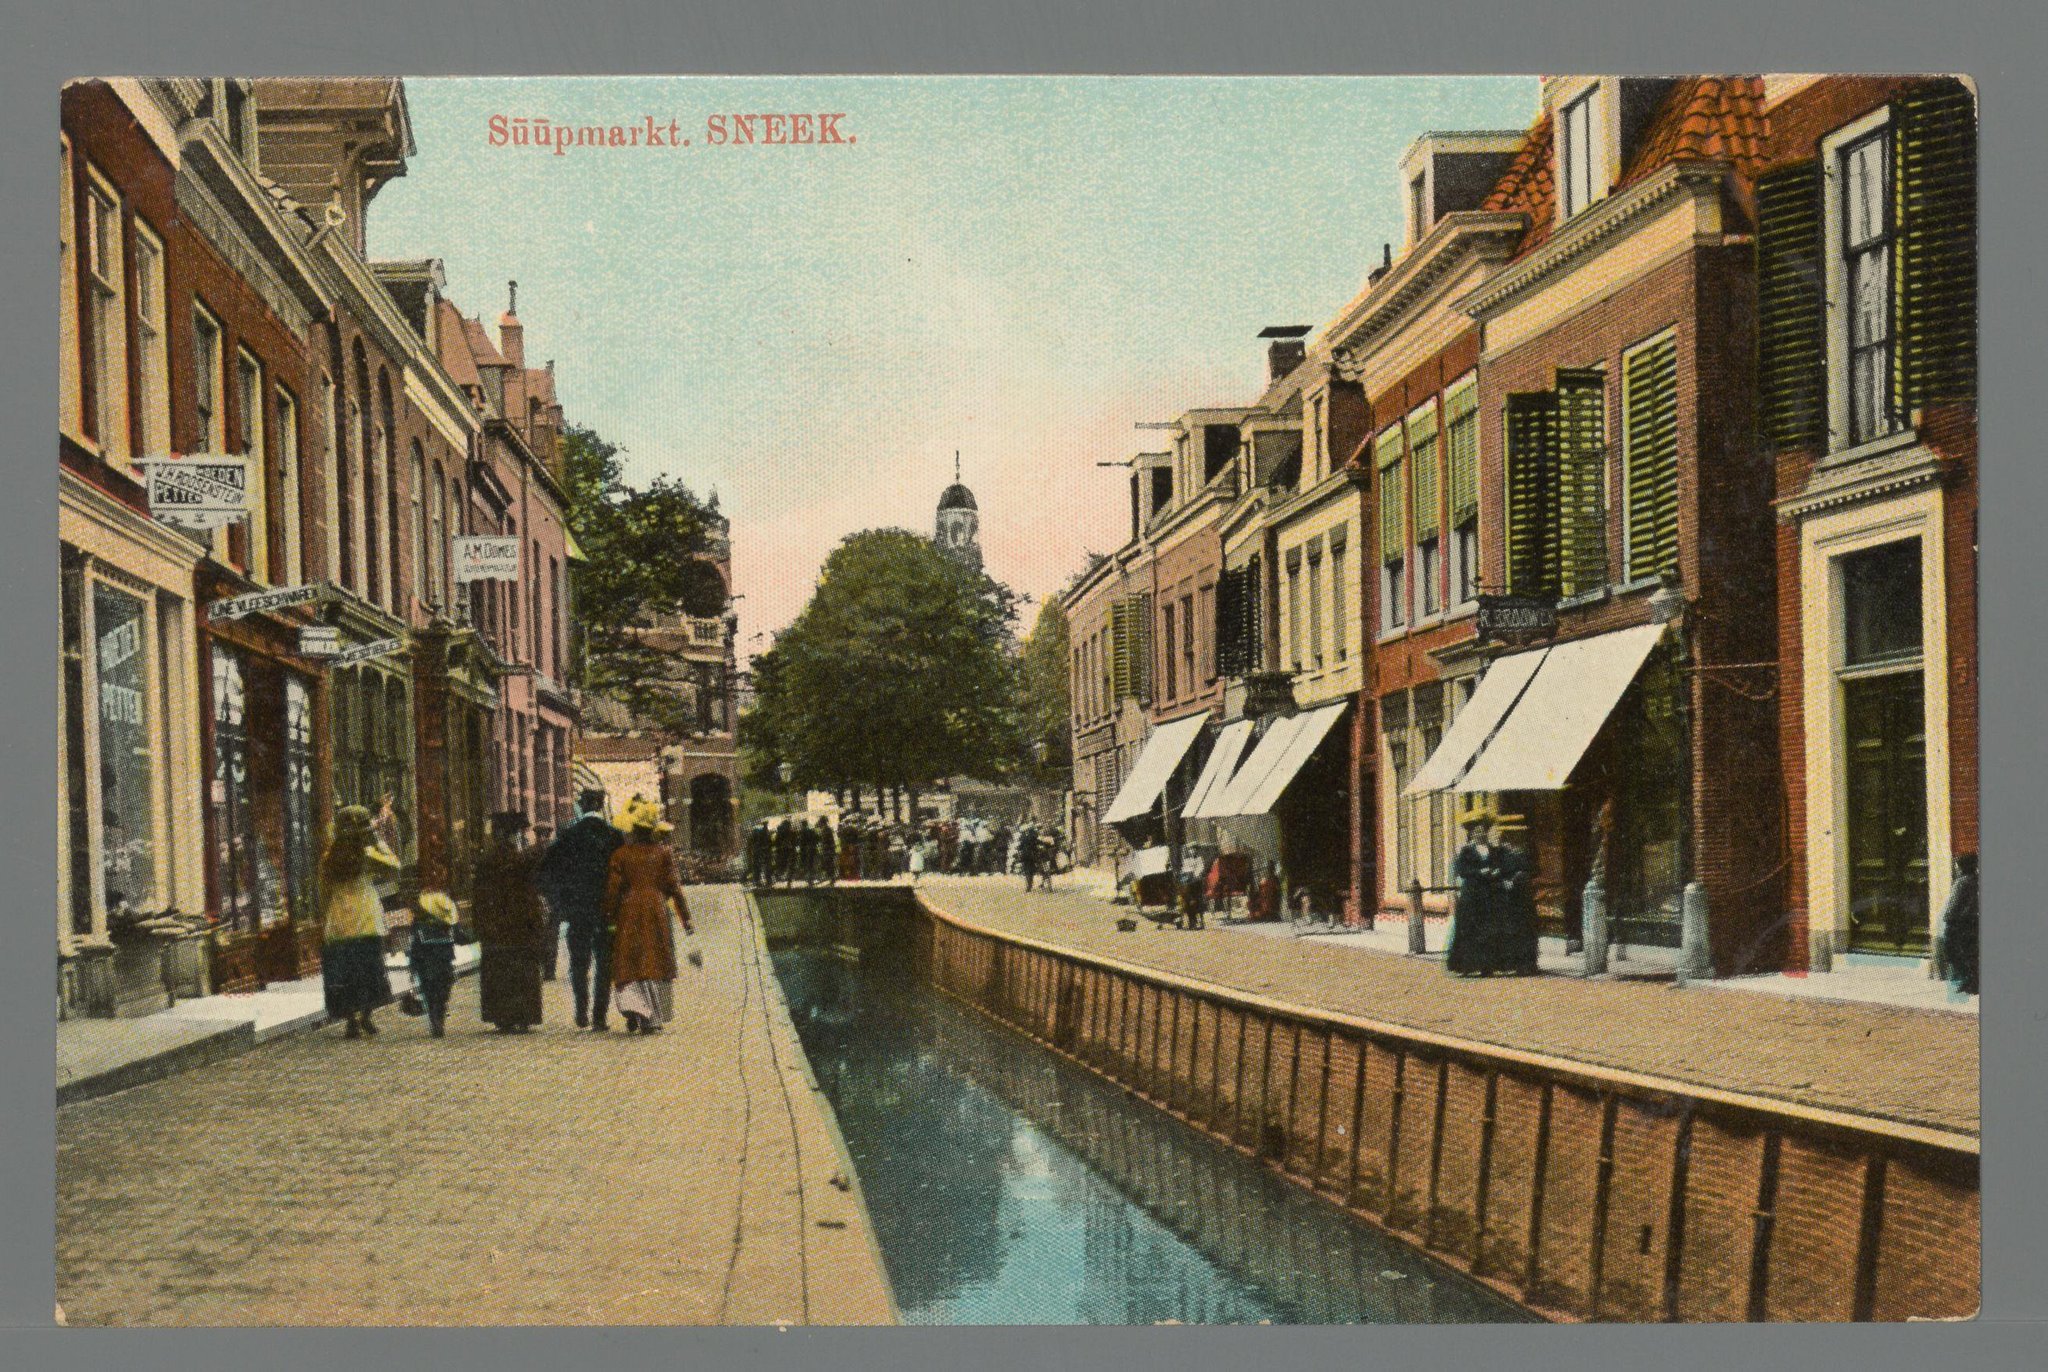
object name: photomechanical print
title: Sūūpmarkt. Sneek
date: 1905-1930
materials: cardboard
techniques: lithograph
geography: arnhem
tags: shop, store, canal, street, parts of church exterior and annexes: tower